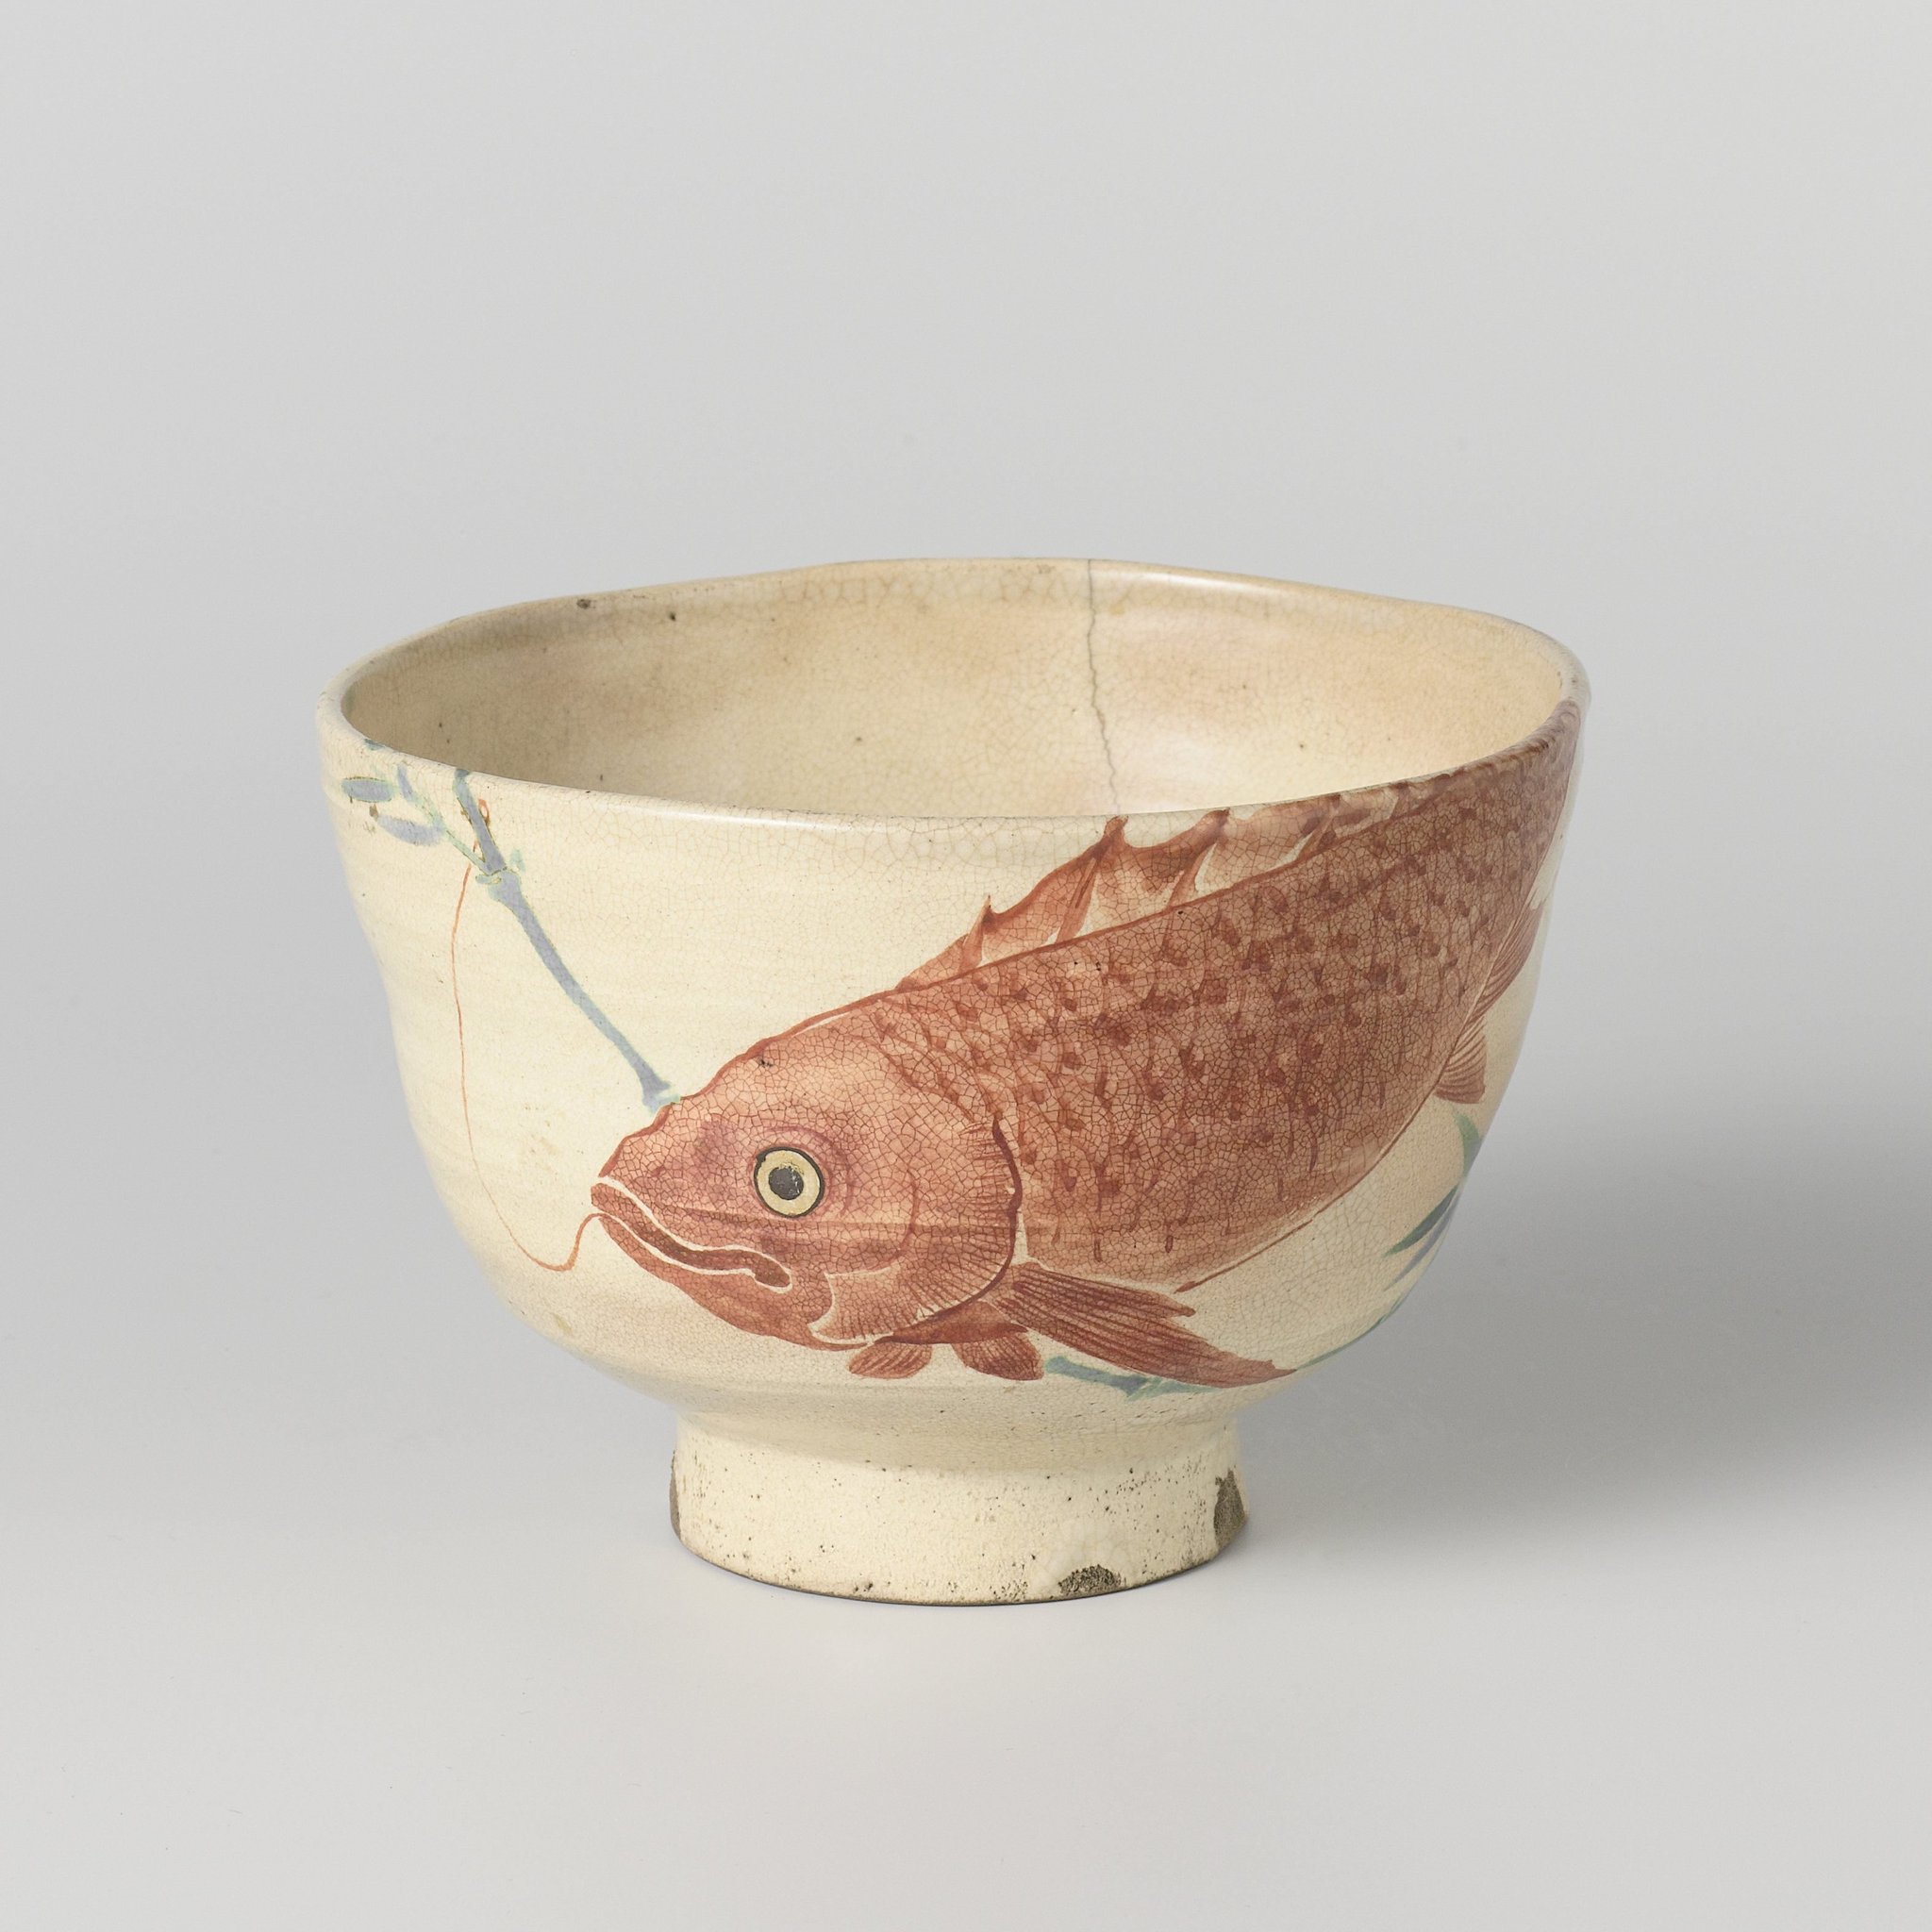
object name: tea bowl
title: Bowl with sea bream, associated with Ebisu, the God of Daily Food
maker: Anonymous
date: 1800-1899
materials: glaze, gold, paint, stoneware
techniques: firing, gilding, turning, vitrification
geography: japan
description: Theekom van steengoed, bedekt met een crèmekleurig glazuur en beschilderd op het glazuur in blauw, rood, groen, zwart en goud. Doorlopend van de buiten- naar de binnenwand een vis (rode zeebrasem) aan een hengel van bamboe. Een barst in de wand. Een inkeping in de voet. Kyoyaki.